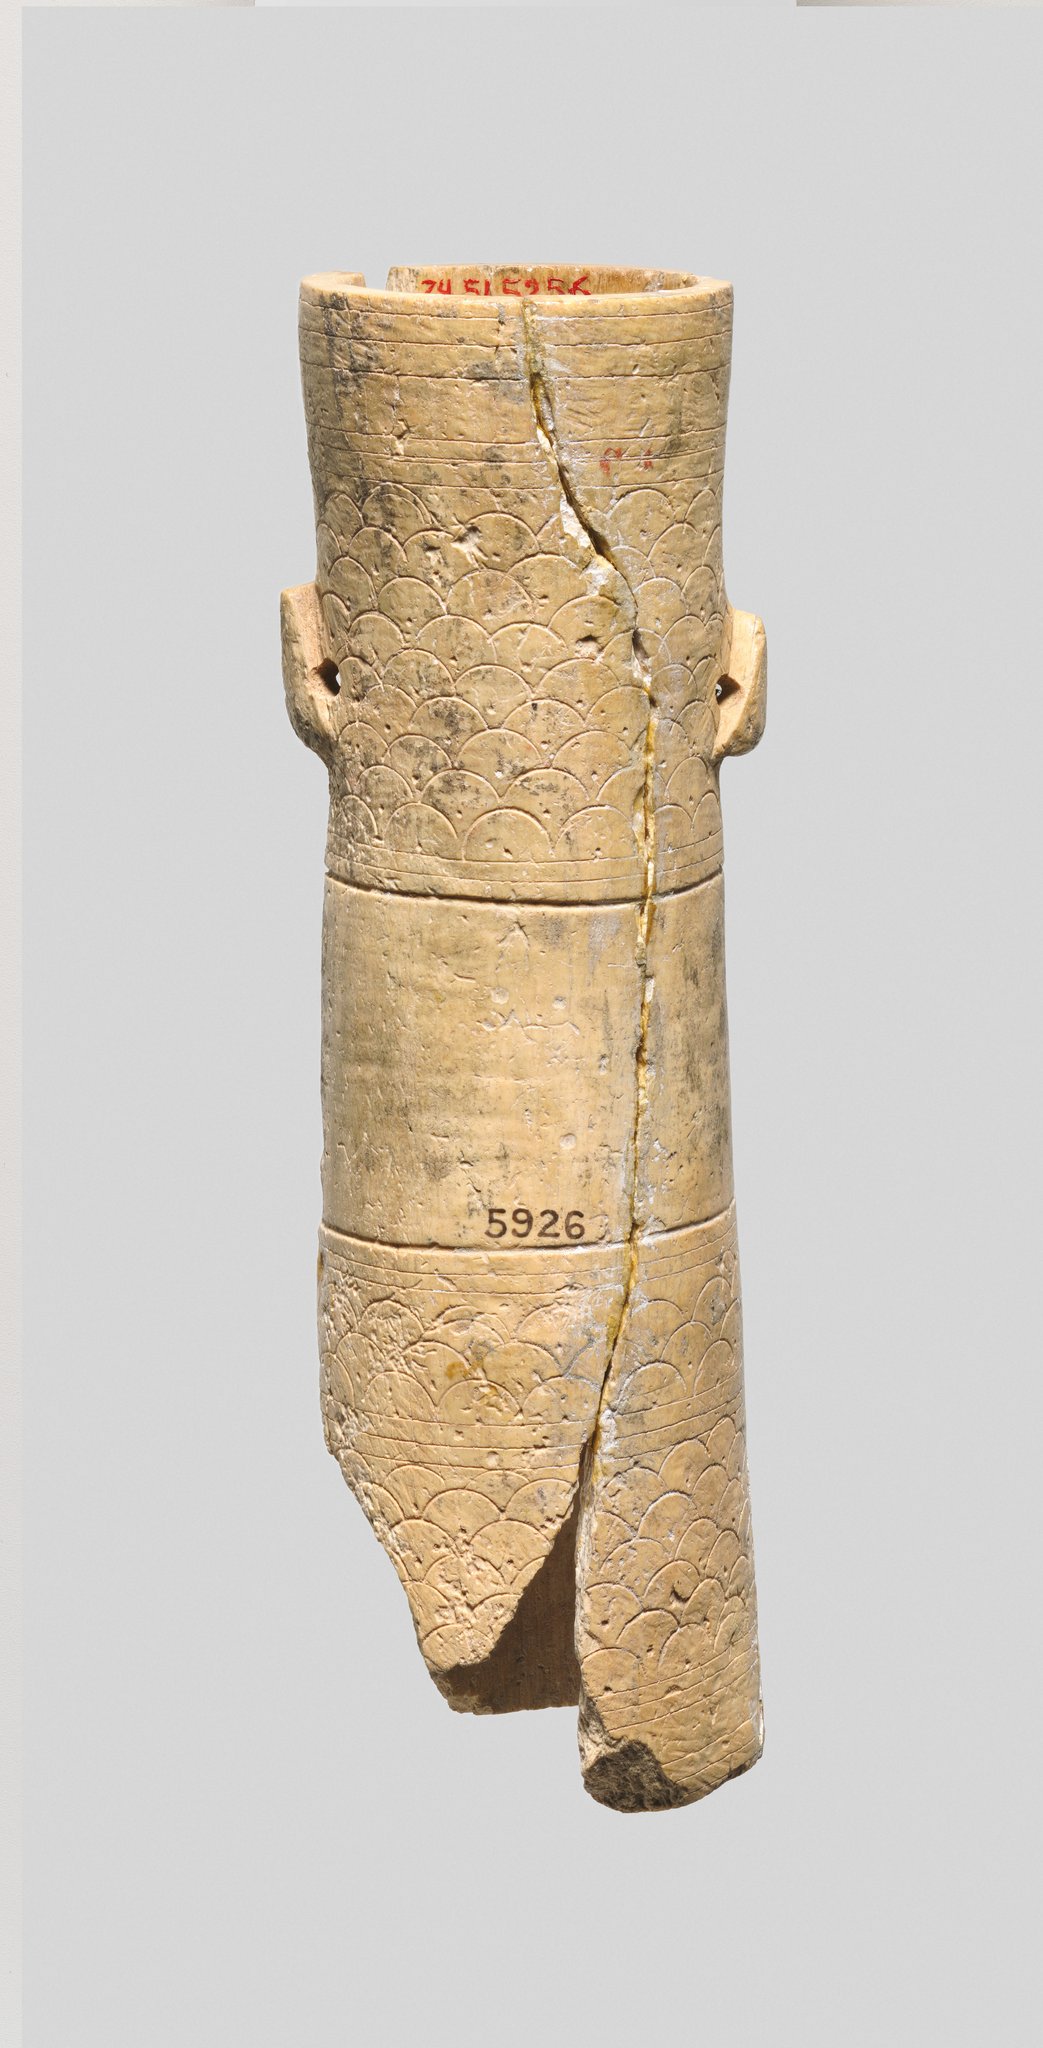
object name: toilet box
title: Narrow ivory box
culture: cypriot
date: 1300-1101 BCE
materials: ivory